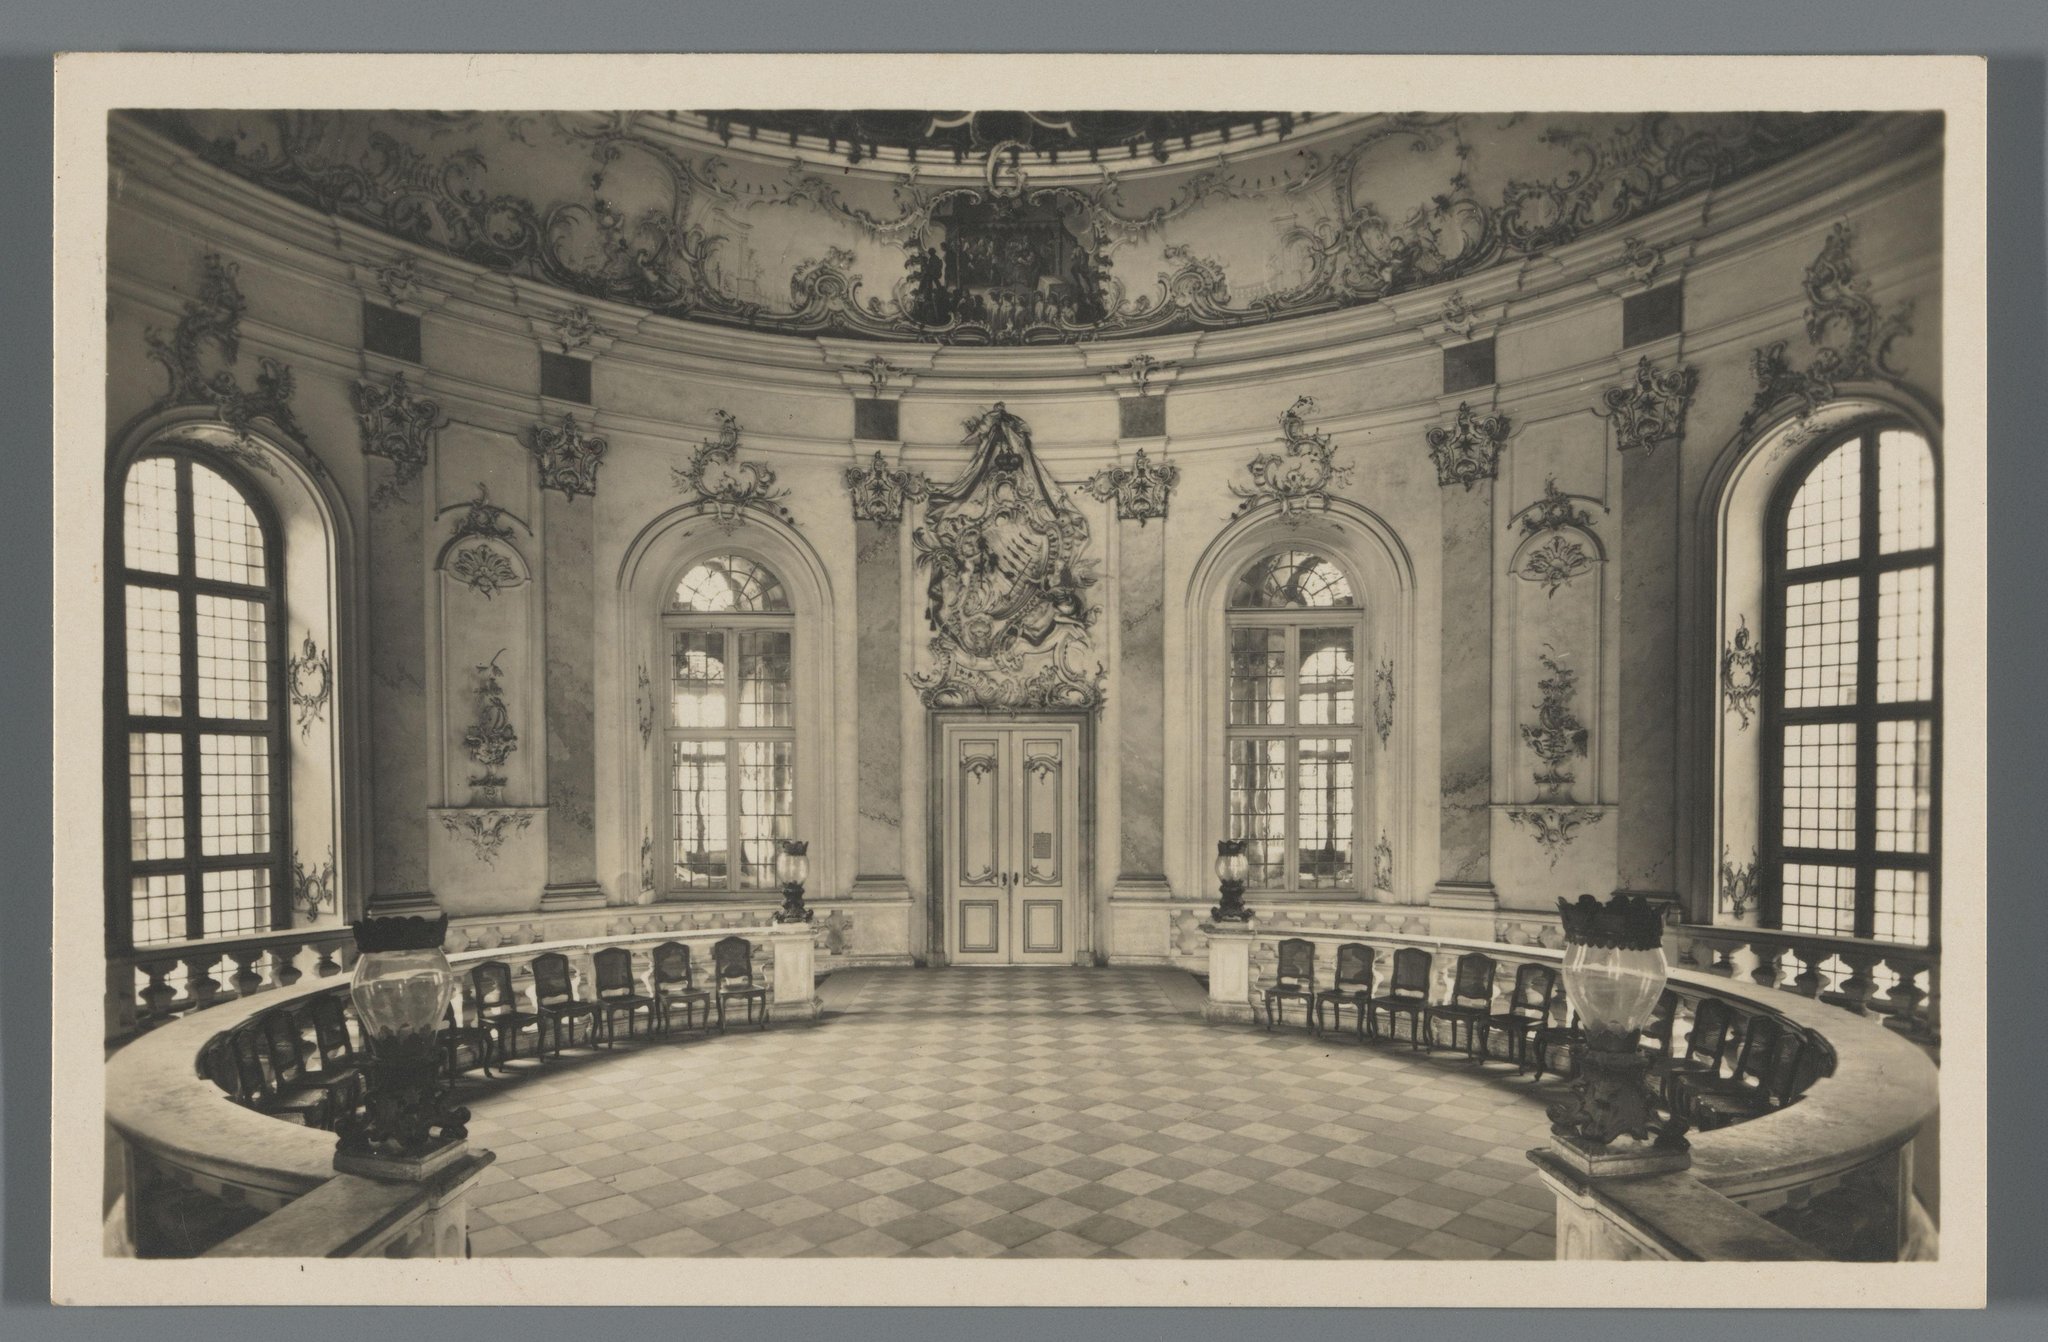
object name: ansichtkaart, prentbriefkaart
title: Zaal in slot Bruchsal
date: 1905-1924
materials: paper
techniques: gelatin silver print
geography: bruchsal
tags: castle - aa - civic architecture: inside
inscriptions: number: ‘Nr. 1659’